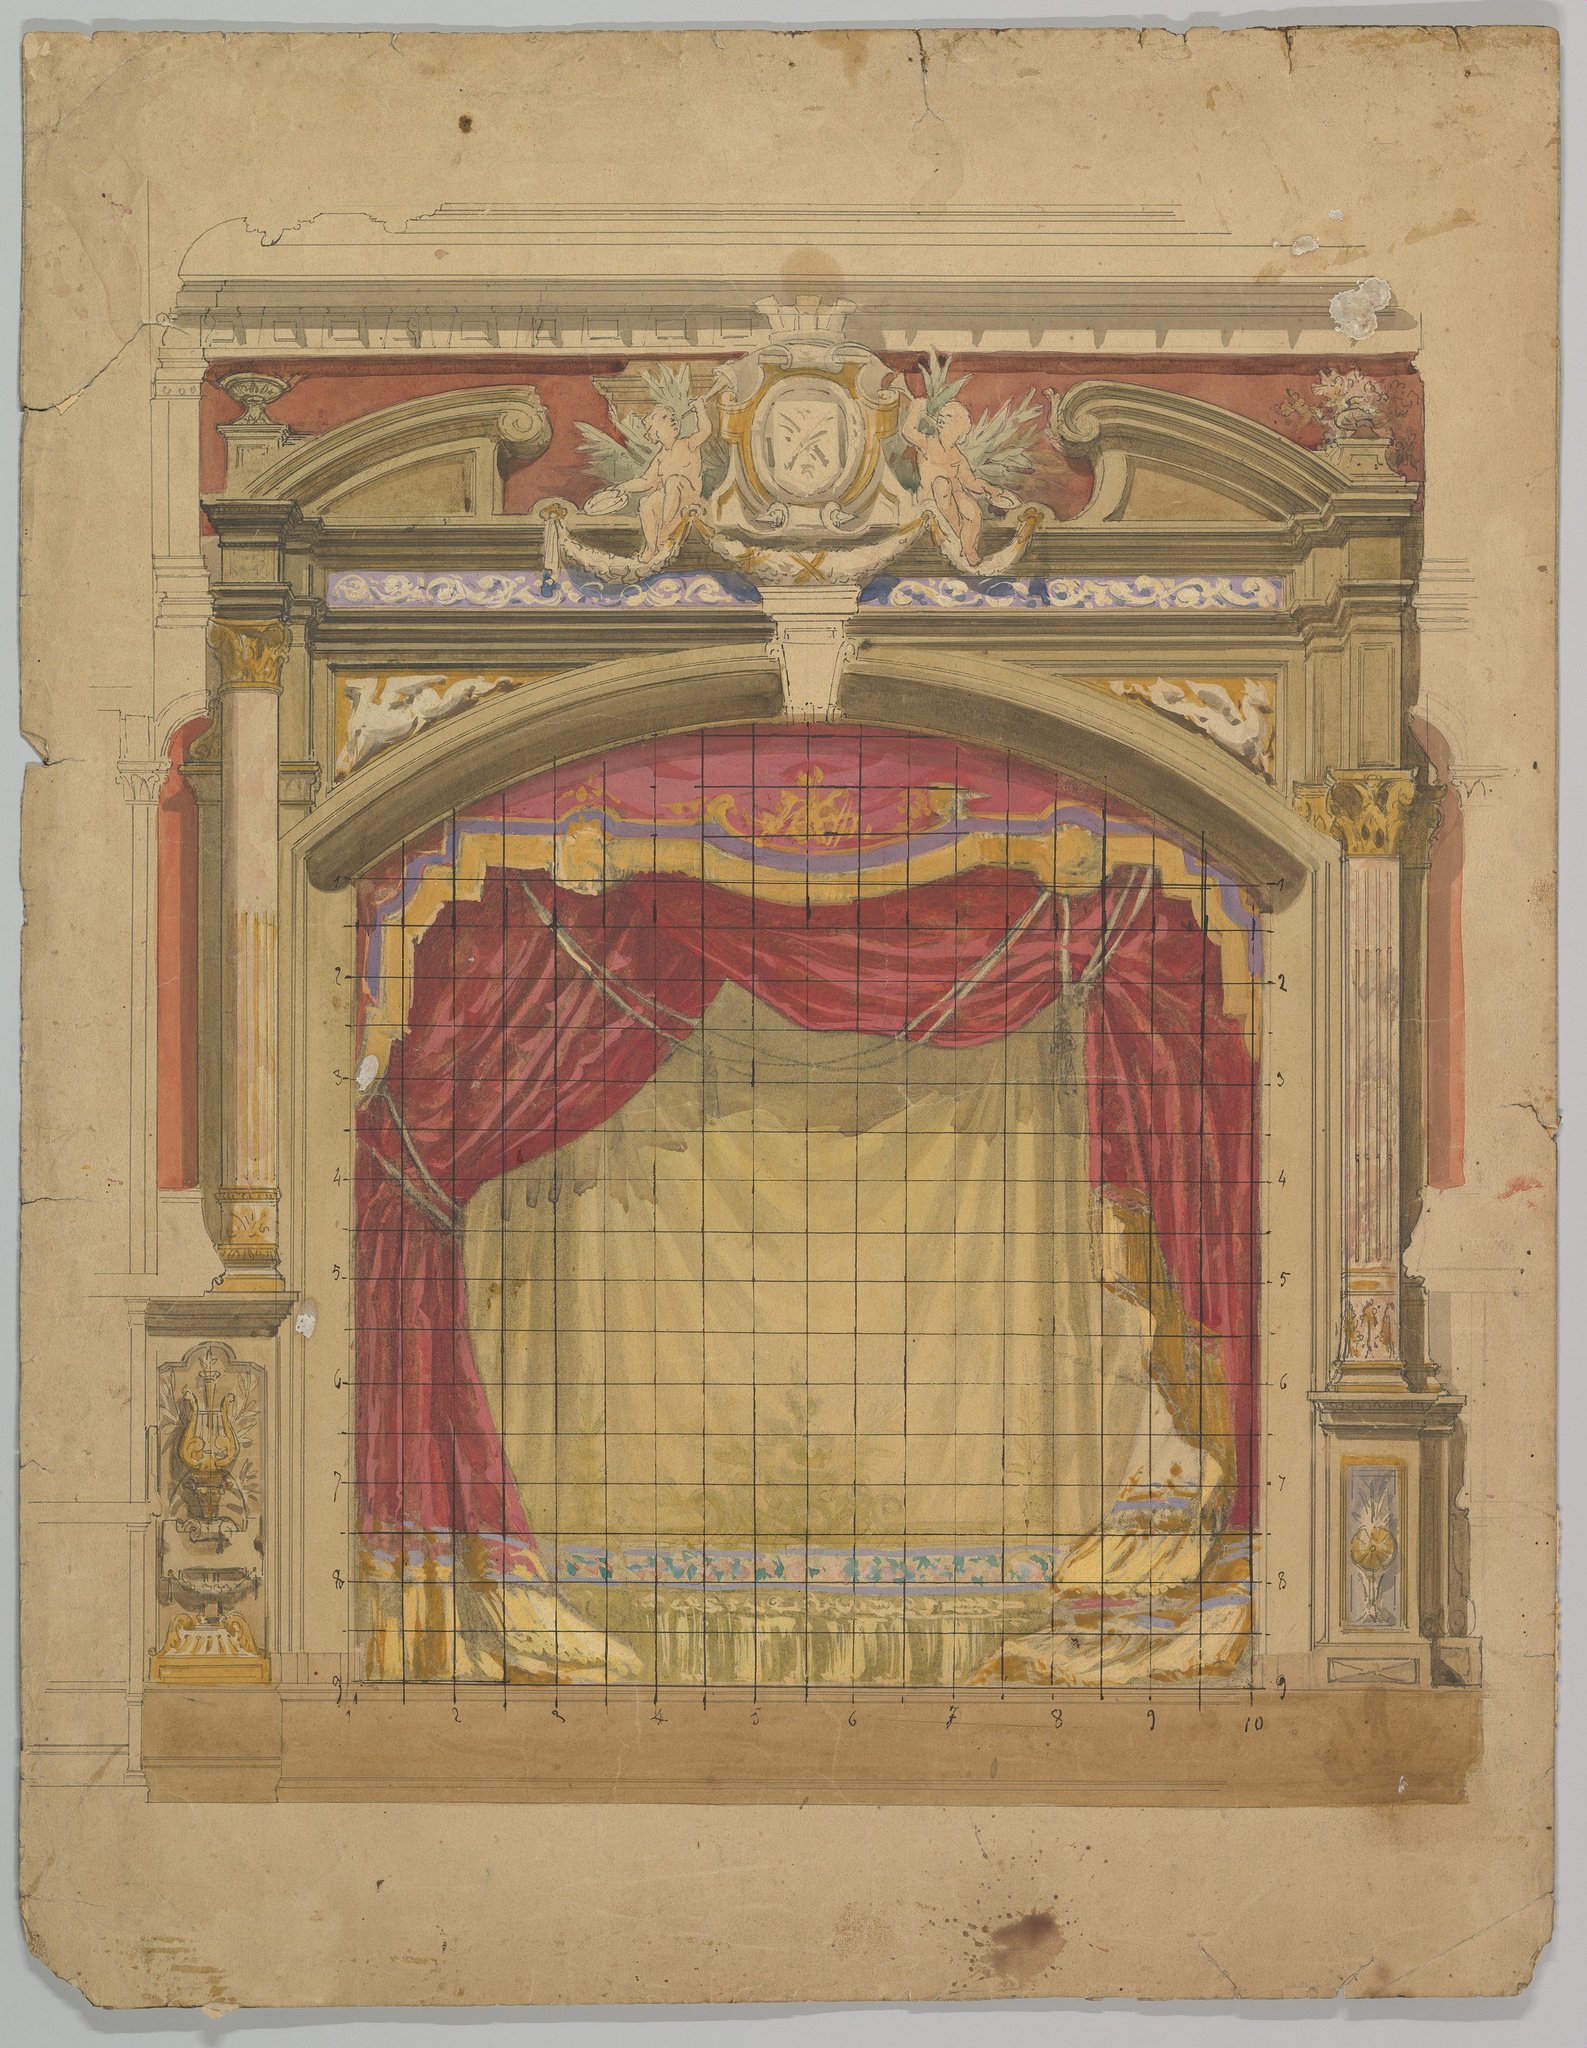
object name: drawing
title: Design for a Stage Set: Casino de St. Etienne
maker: eugène cicéri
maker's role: artist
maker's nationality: french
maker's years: 1813-1890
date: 1830-1890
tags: theatre,curtains,stage design